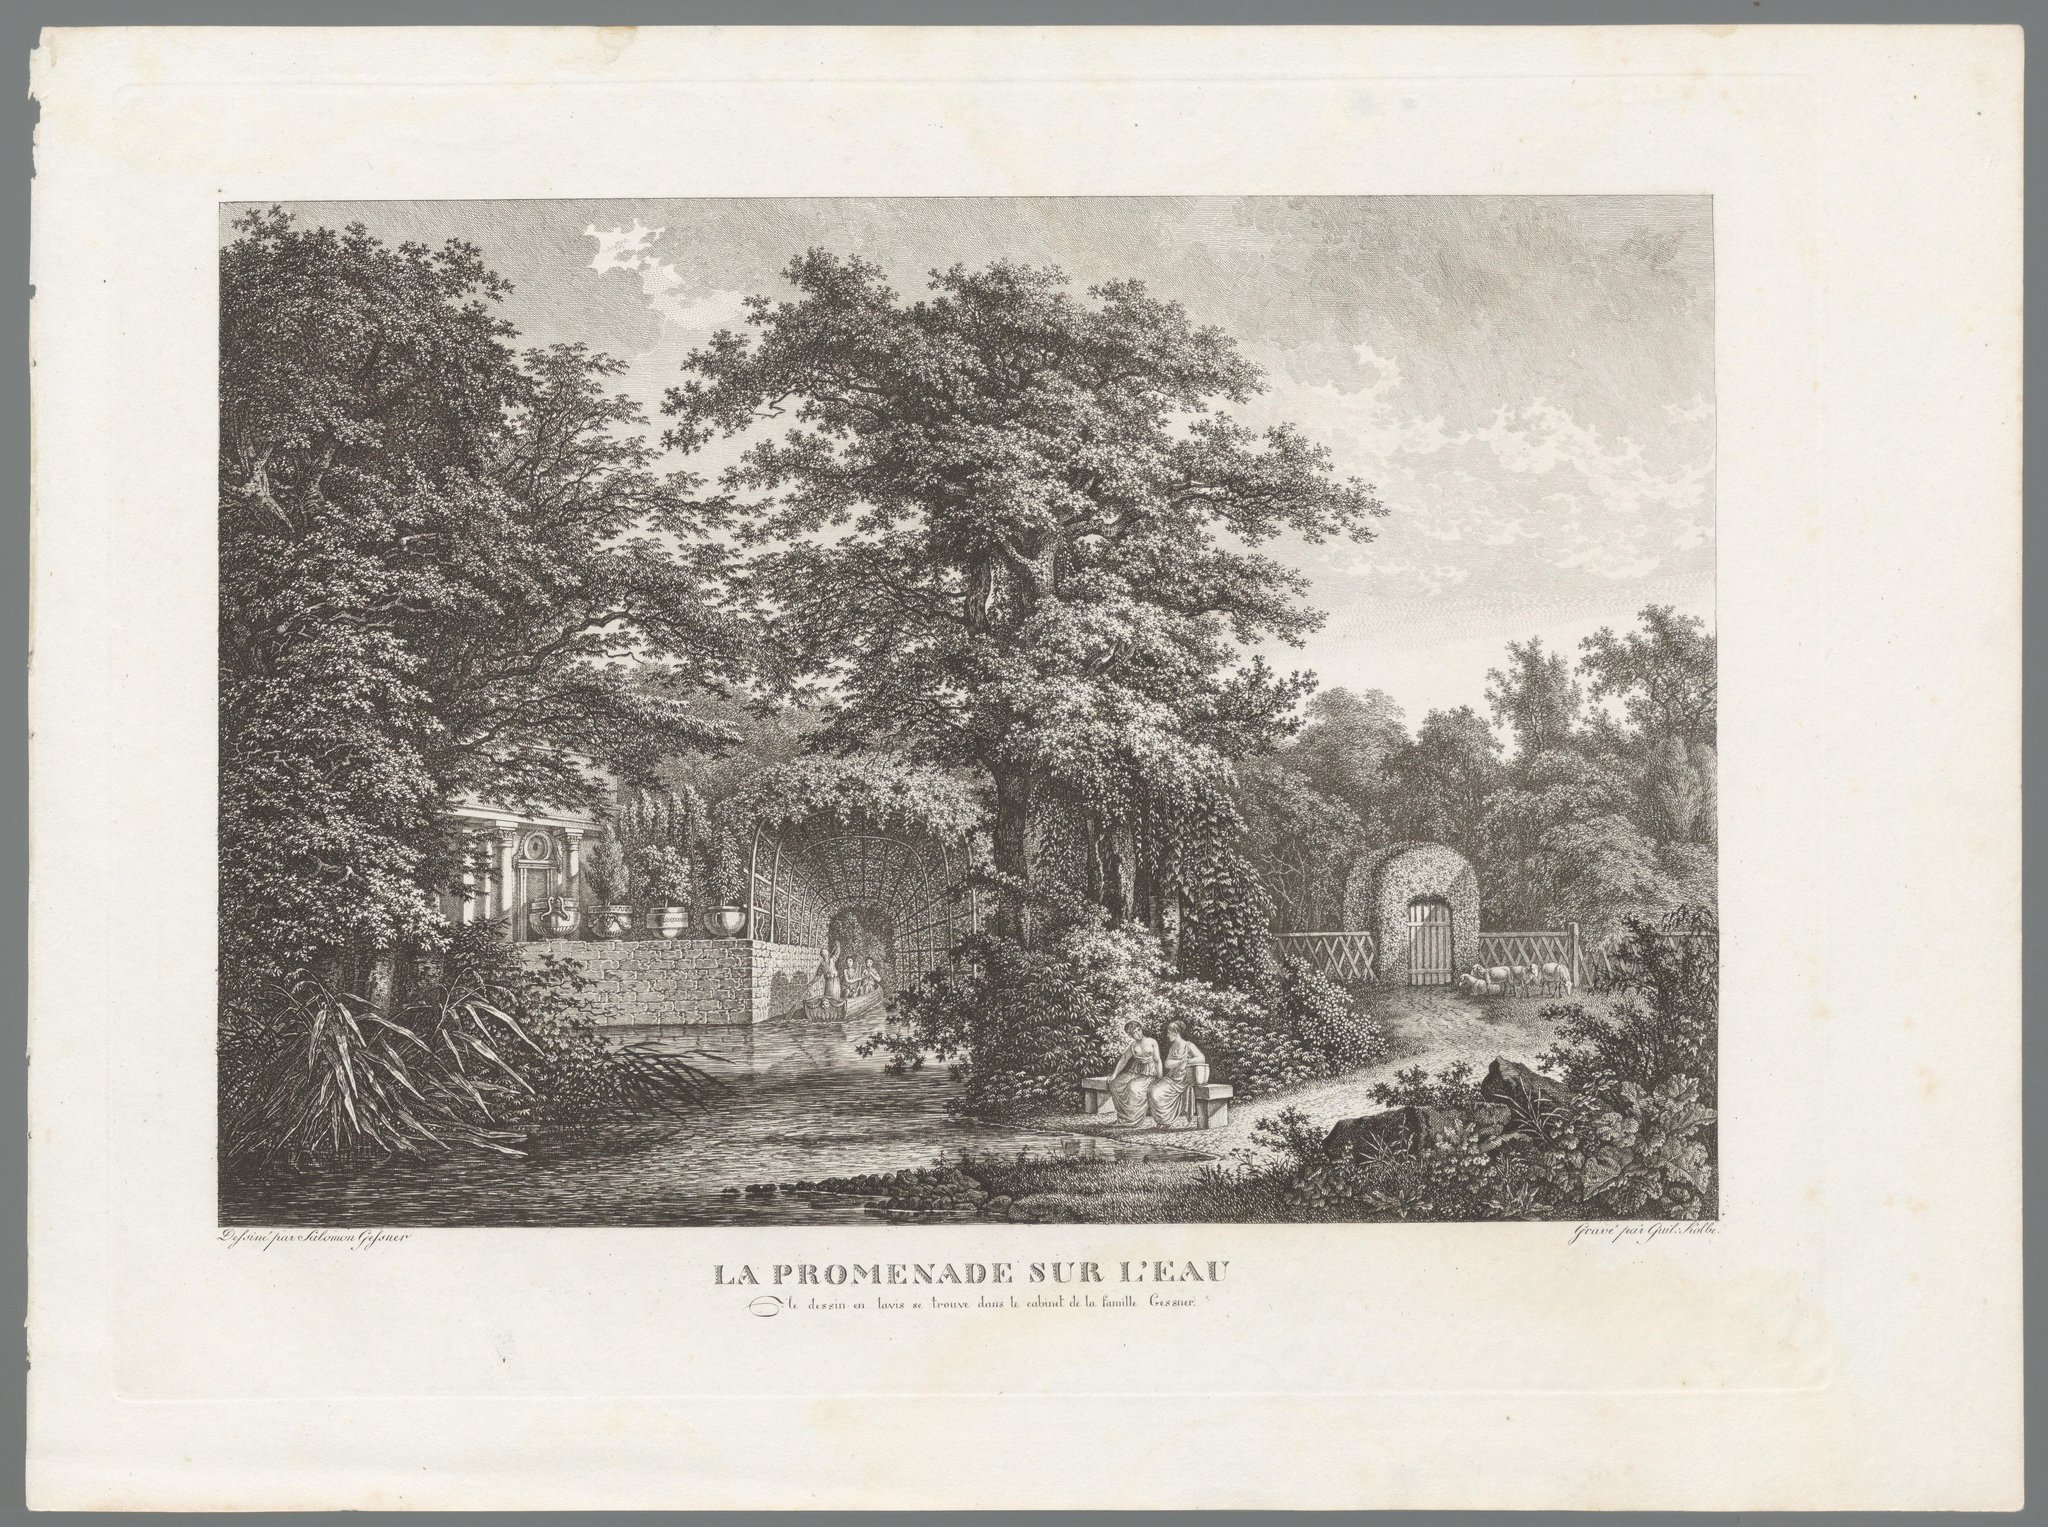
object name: print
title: Collection des tableaux en gouache et des dessins de Salomon Gessner. Gravés à l'eau forte par Guil. Kolbe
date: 1811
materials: paper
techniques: etching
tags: enjoying nature, rural housing, e.g. country-house, villa, cottage, brook, pergola, pastorals, arcadian scenes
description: Deze prent is gemaakt voor een serie uit 1811 getiteld: Collection des tableaux en gouache et des dessins de Salomon Gessner. Gravés à l'eau forte par Guil. Kolbe. De gehele serie is in het bezit van het RMA onder inv. nr. RP-P-2005-184.